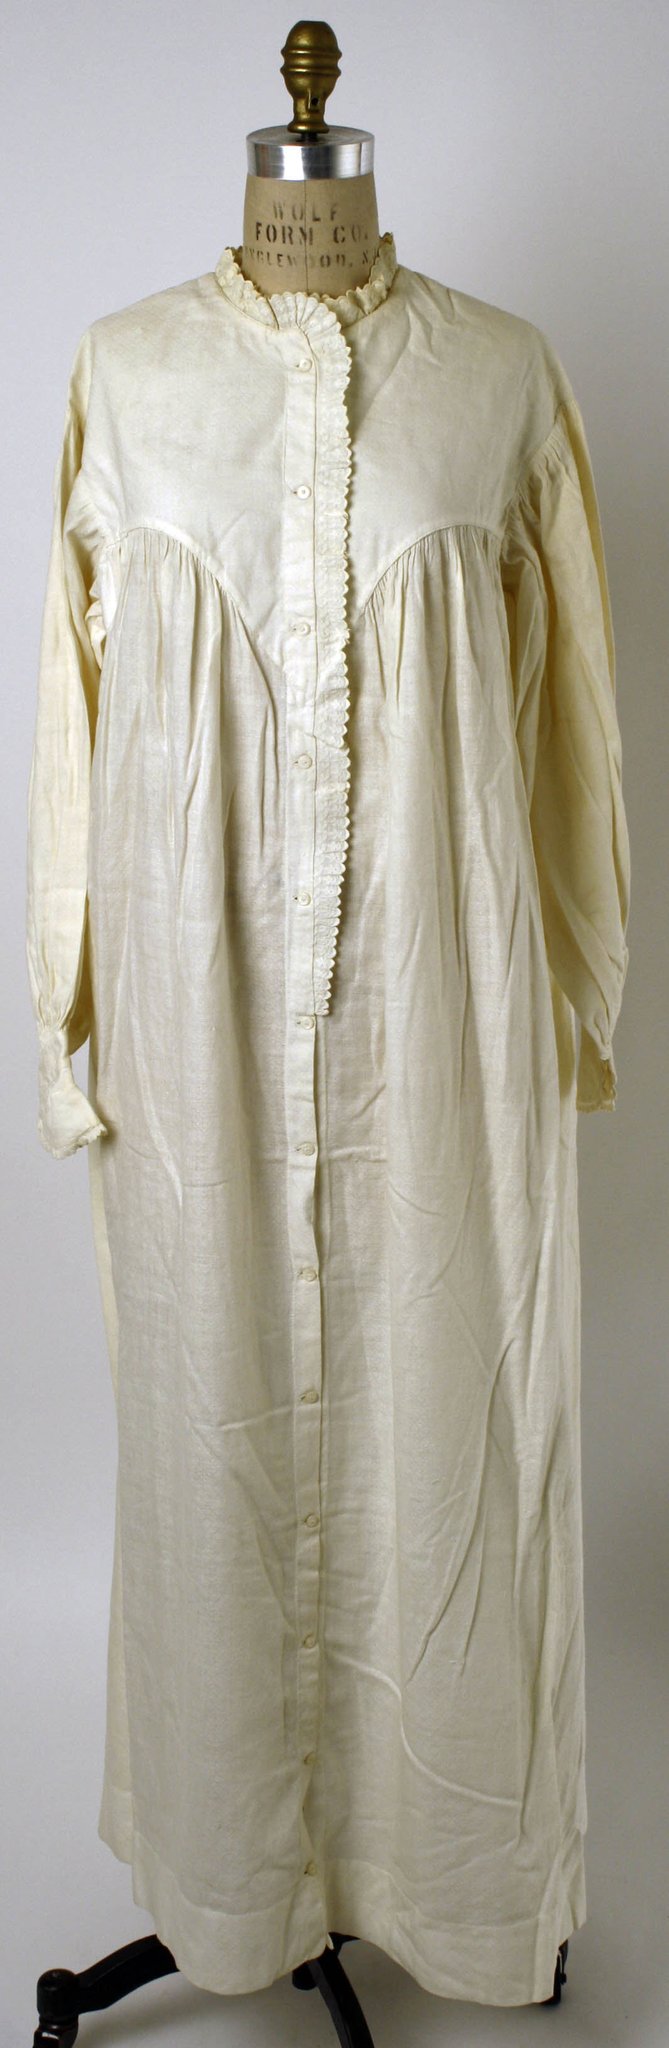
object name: nightgown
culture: american or european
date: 1856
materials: cotton